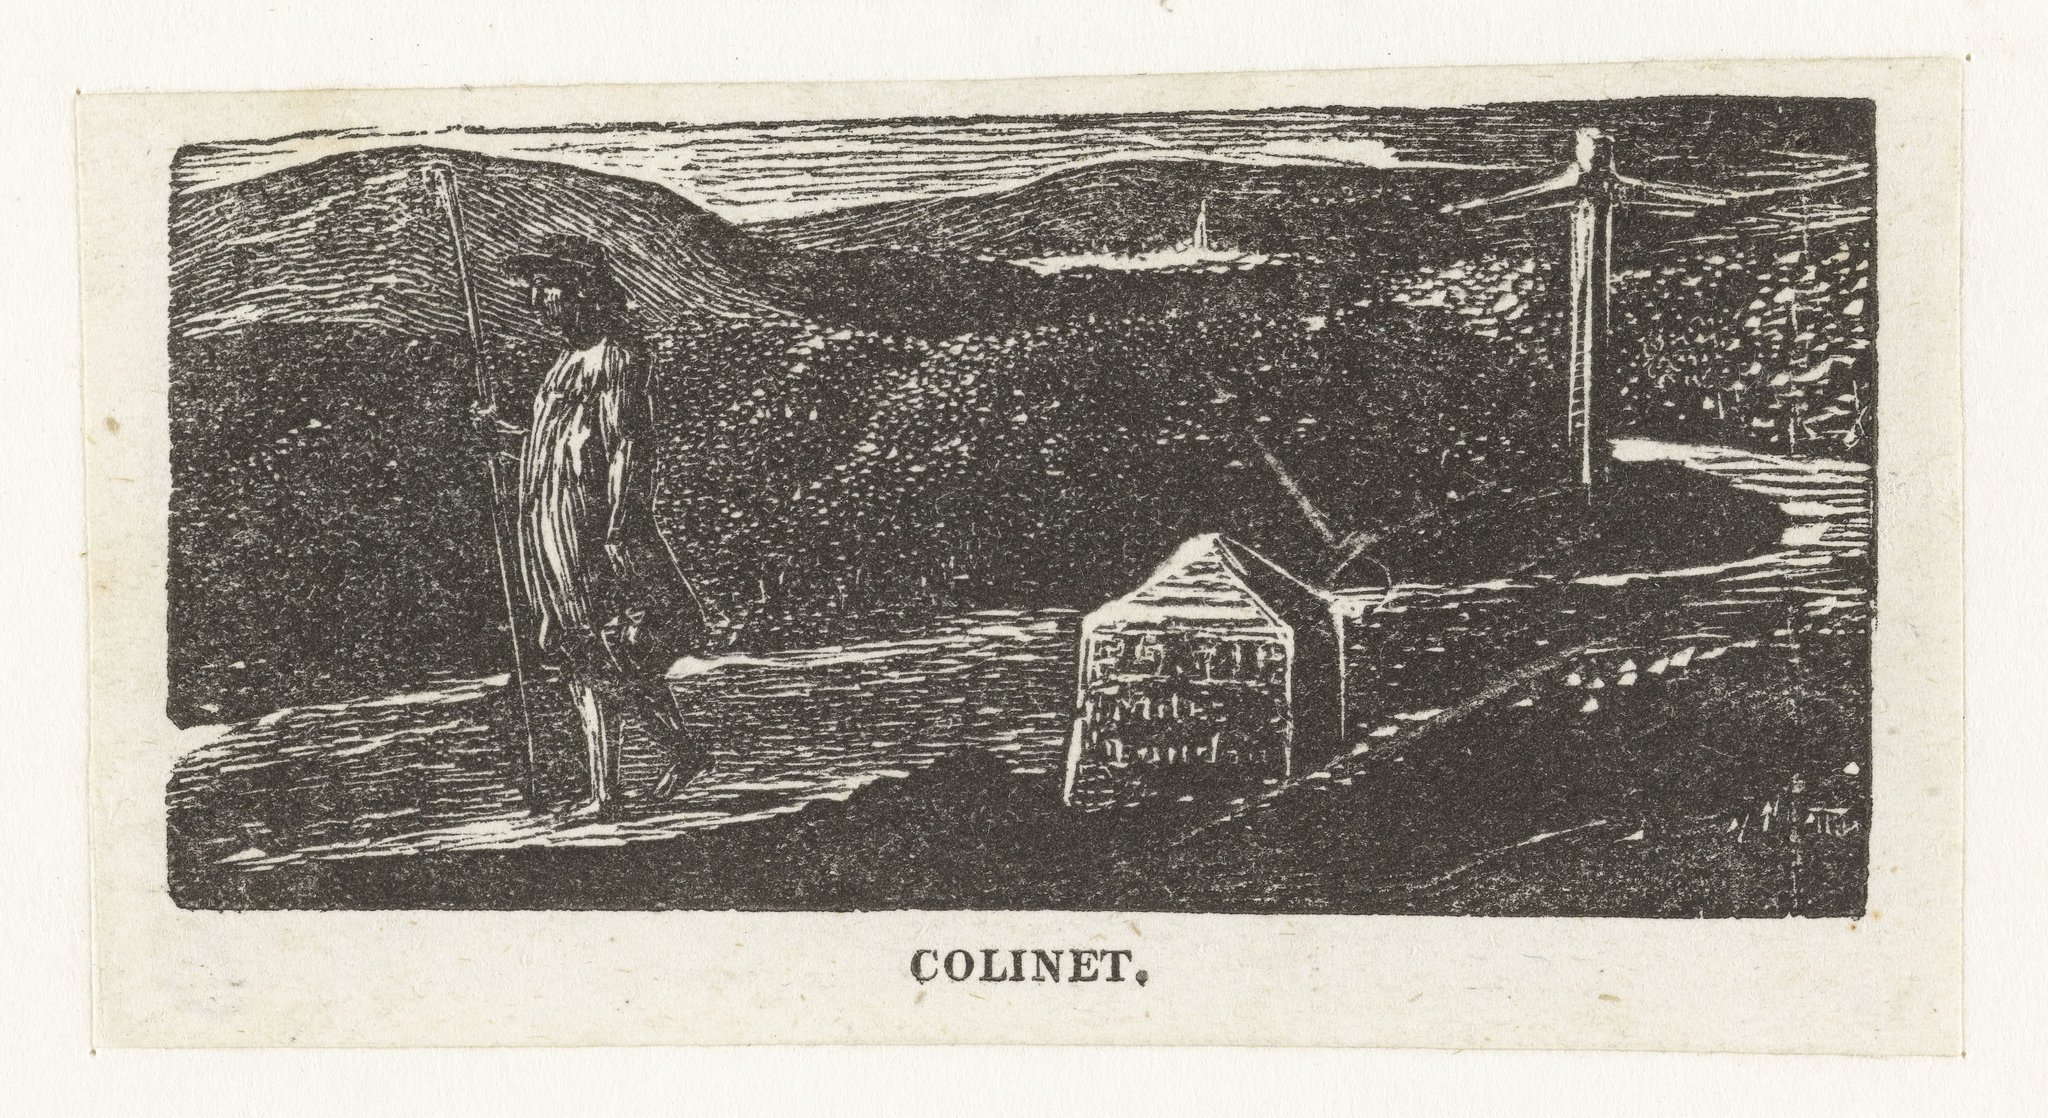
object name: book illustration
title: Colinet's journey, a milestone markes "LXII miles to London"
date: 1820-1821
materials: paper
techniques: engraving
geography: england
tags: walking, illustration ~ printed matter, book, milestone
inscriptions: collector's mark: Lugt 2228, collector's mark: Lugt 2760, inscription: ‘Colinet’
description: Illustratie uit "Imitations of Ecologue I", de achttiende-eeuwse imitatie van de eerste Ecloge van Vergilius, geschreven door Ambrose Philips, waarin twee herders Thenot and Colinet met elkaar converseren. De prent maakt deel uit van een serie houtgravures die als illustratie was bedoeld voor het schoolboek "The Pastorals of Virgil", uitgegeven in 1821. De opdracht voor deze prenten is gegeven door Dr R.J. Thornton. Botke, K.